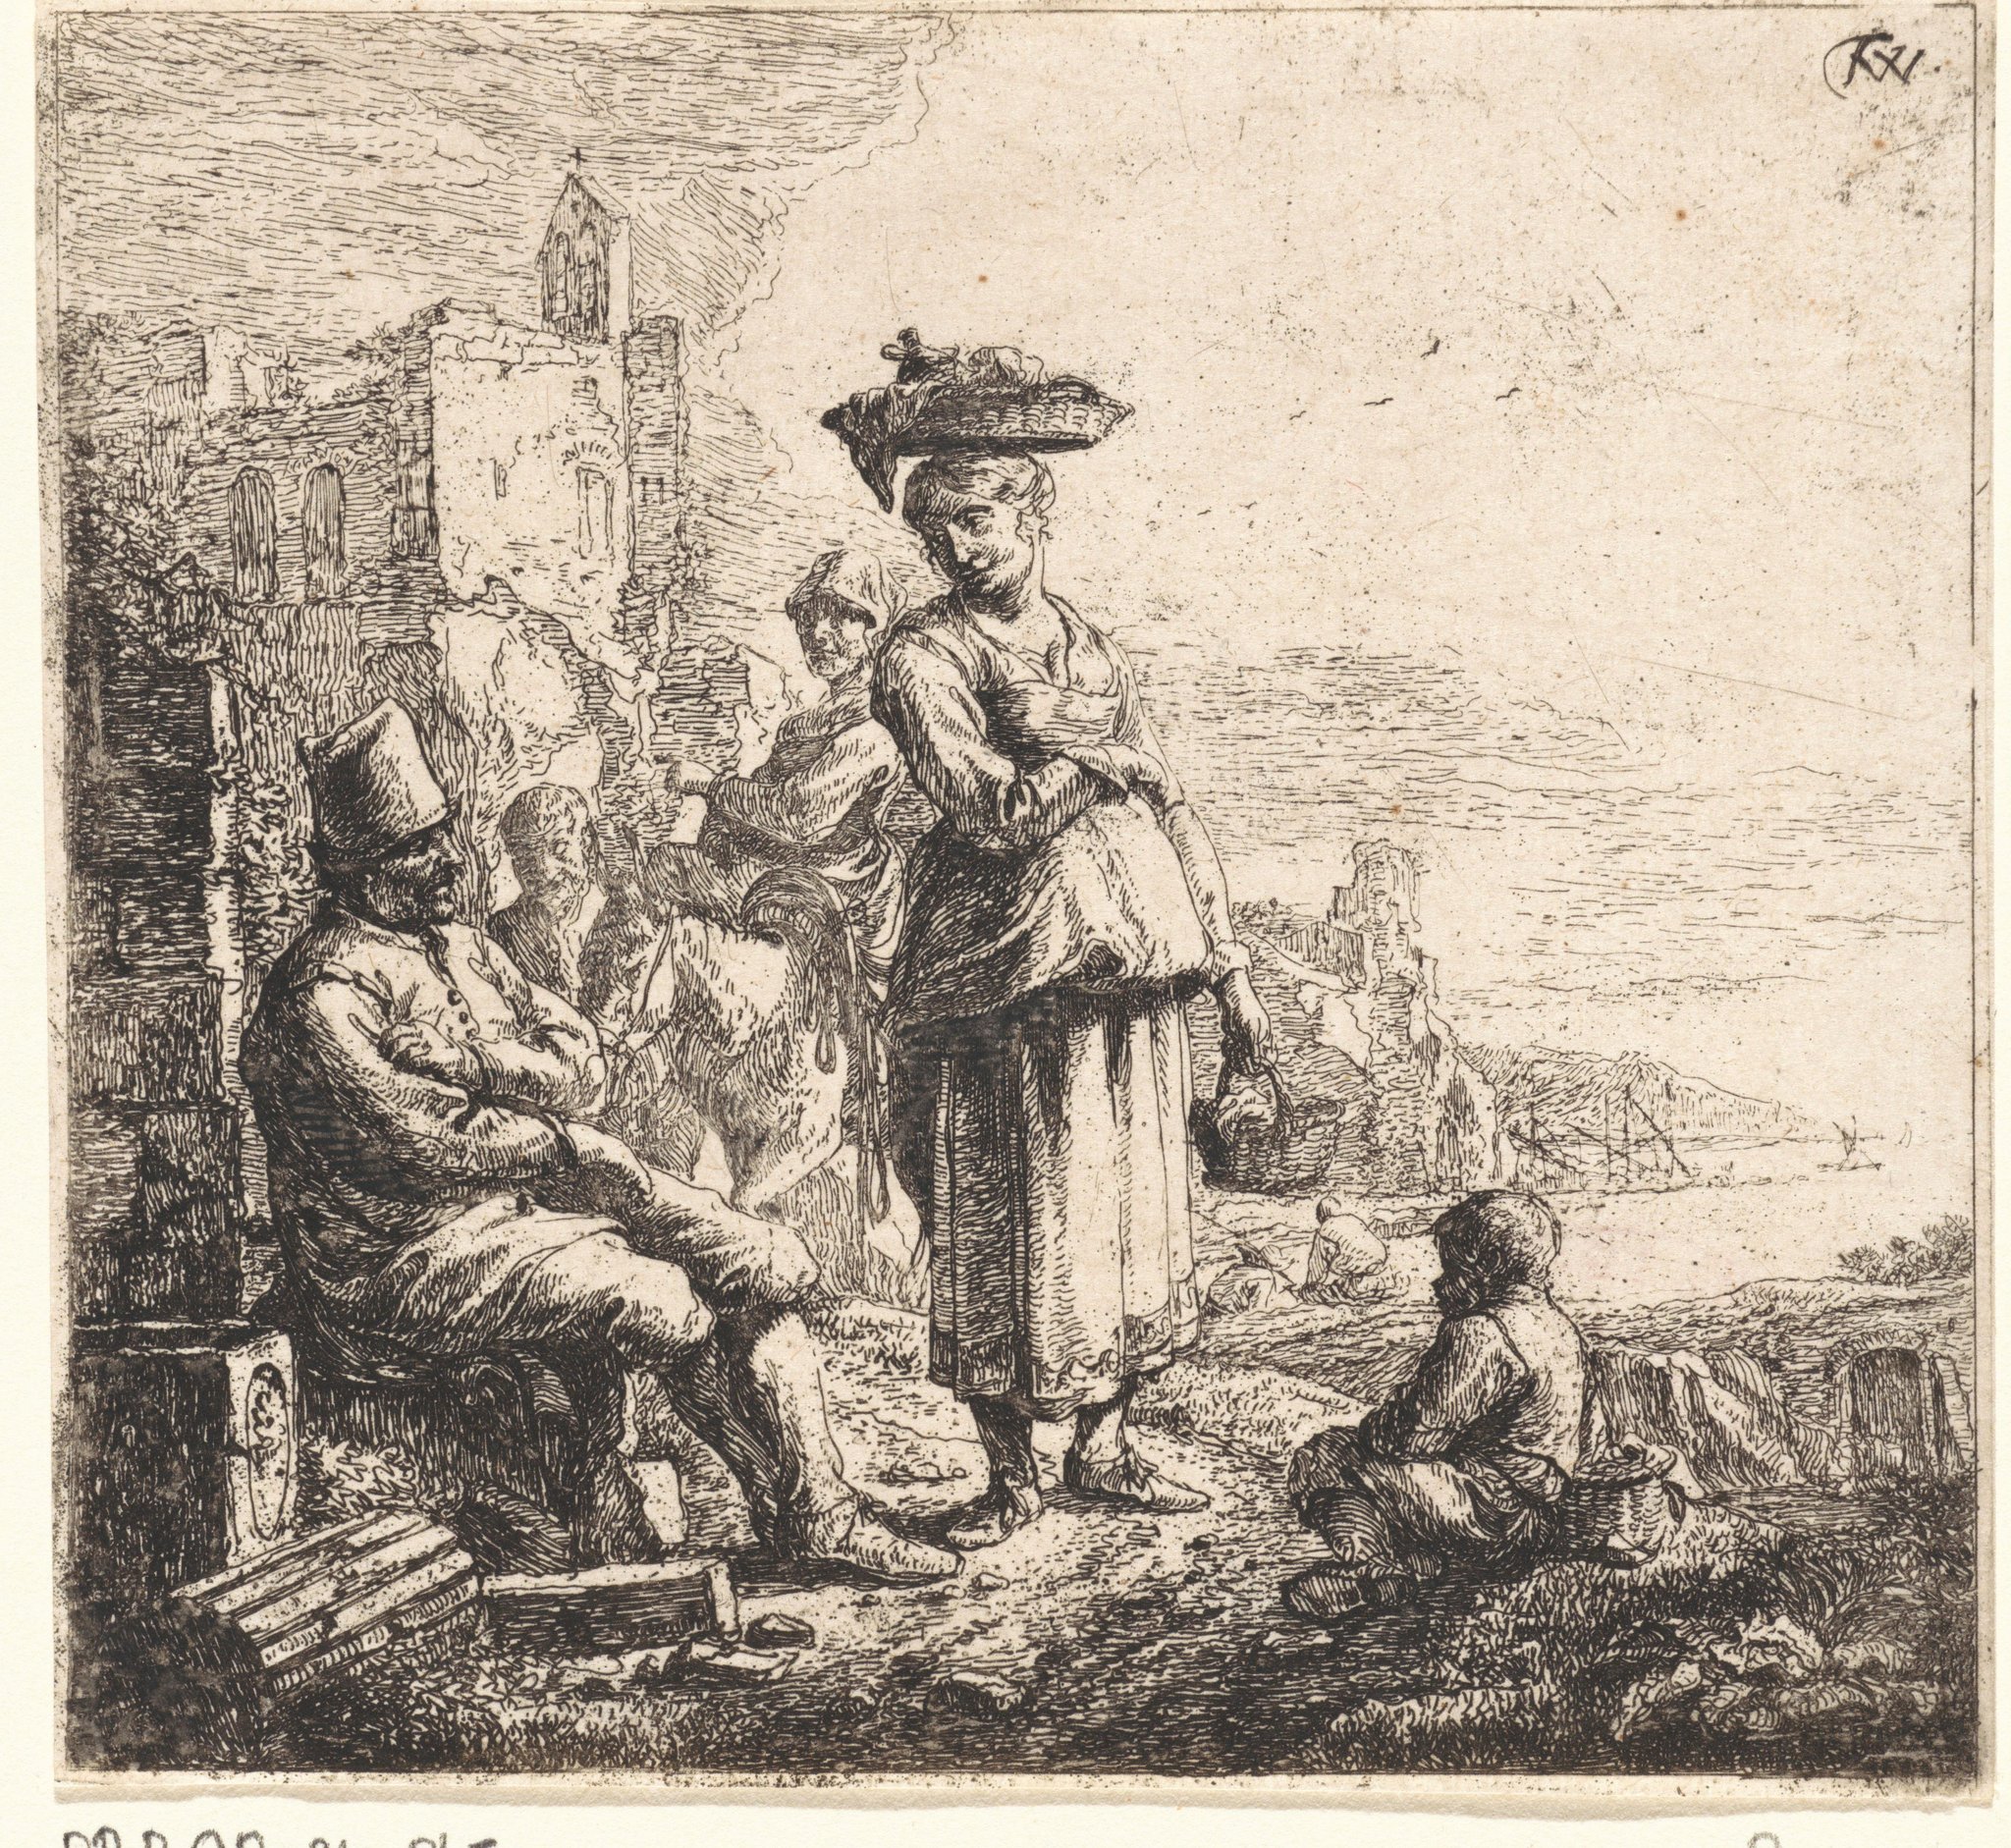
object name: print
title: Vrouw die twee manden draagt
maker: thomas wijck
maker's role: draughtsman, painter, print maker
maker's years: 1616-1677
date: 1626-1677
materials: paper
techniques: etching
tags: harbour, carrying something in basket, bag, rucksack, etc., church (exterior)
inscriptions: collector's mark: Lugt 240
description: Een vrouw in de haven, met een mand op het hoofd en een mand in de hand. Ze kijkt om naar een man. Een kind zit langs het pad. Op de achtergrond een kerk op een berg.